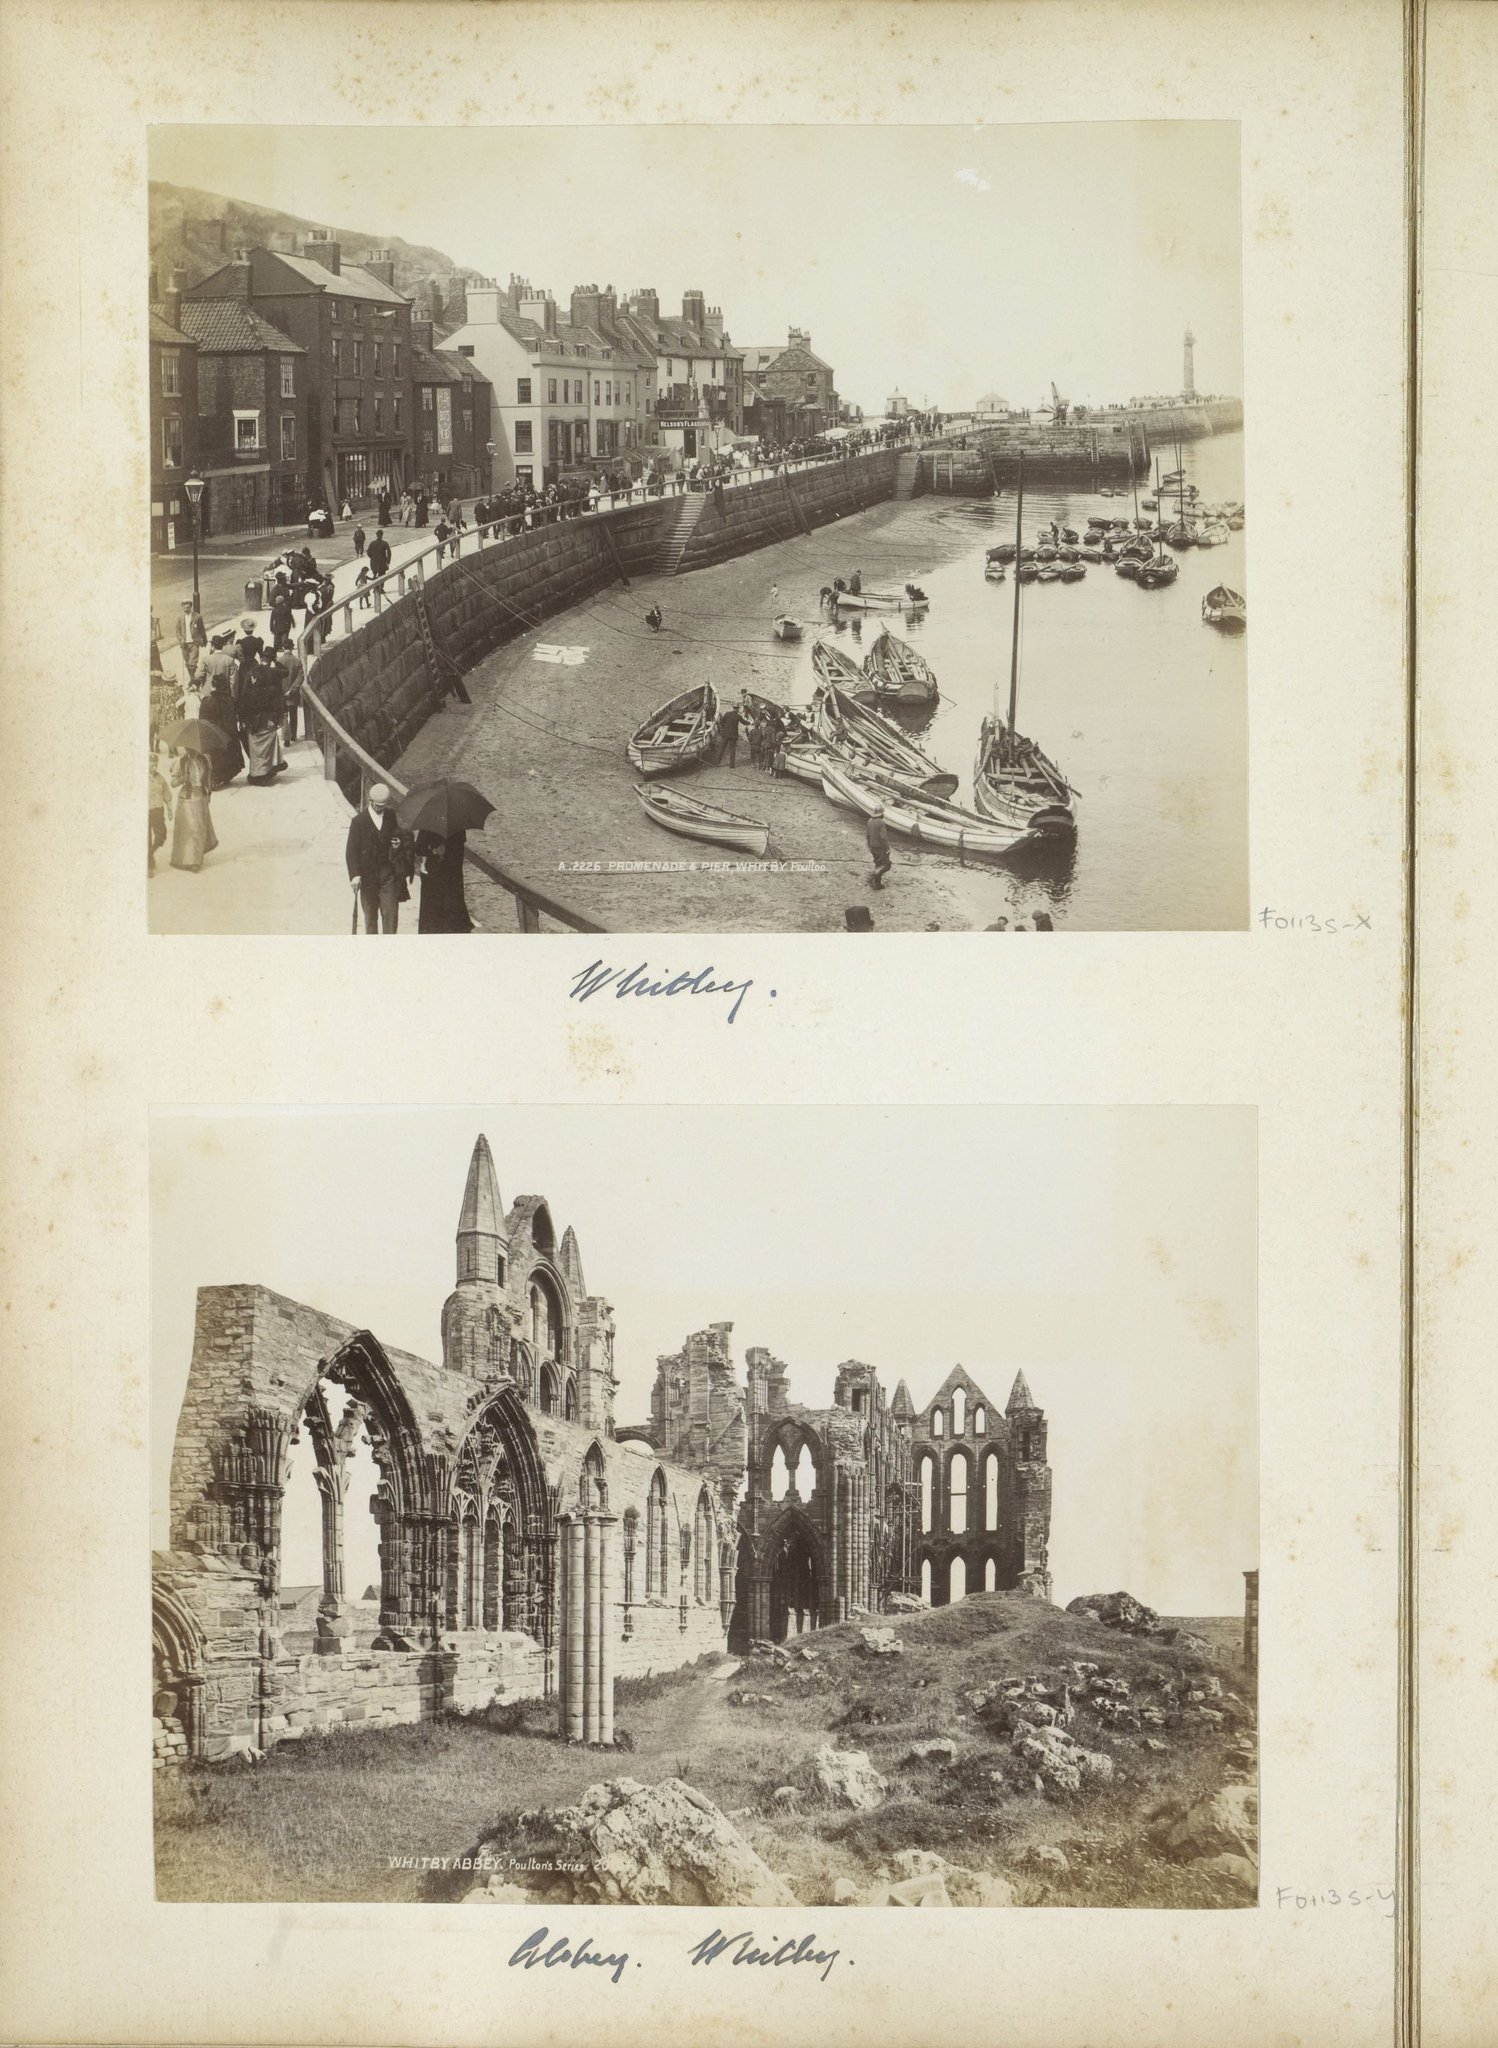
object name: album leaf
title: Gezicht op de ruïne van de abdij van Whitby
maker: poulton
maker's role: fotograaf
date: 1898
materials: paper, photographic support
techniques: albumen print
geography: whitby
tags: ruin of a dwelling, house, castle, etc.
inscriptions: negative number: ‘2[...]’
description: Onderdeel van Reisalbum met foto's van bezienswaardigheden in Engeland en Frankrijk.